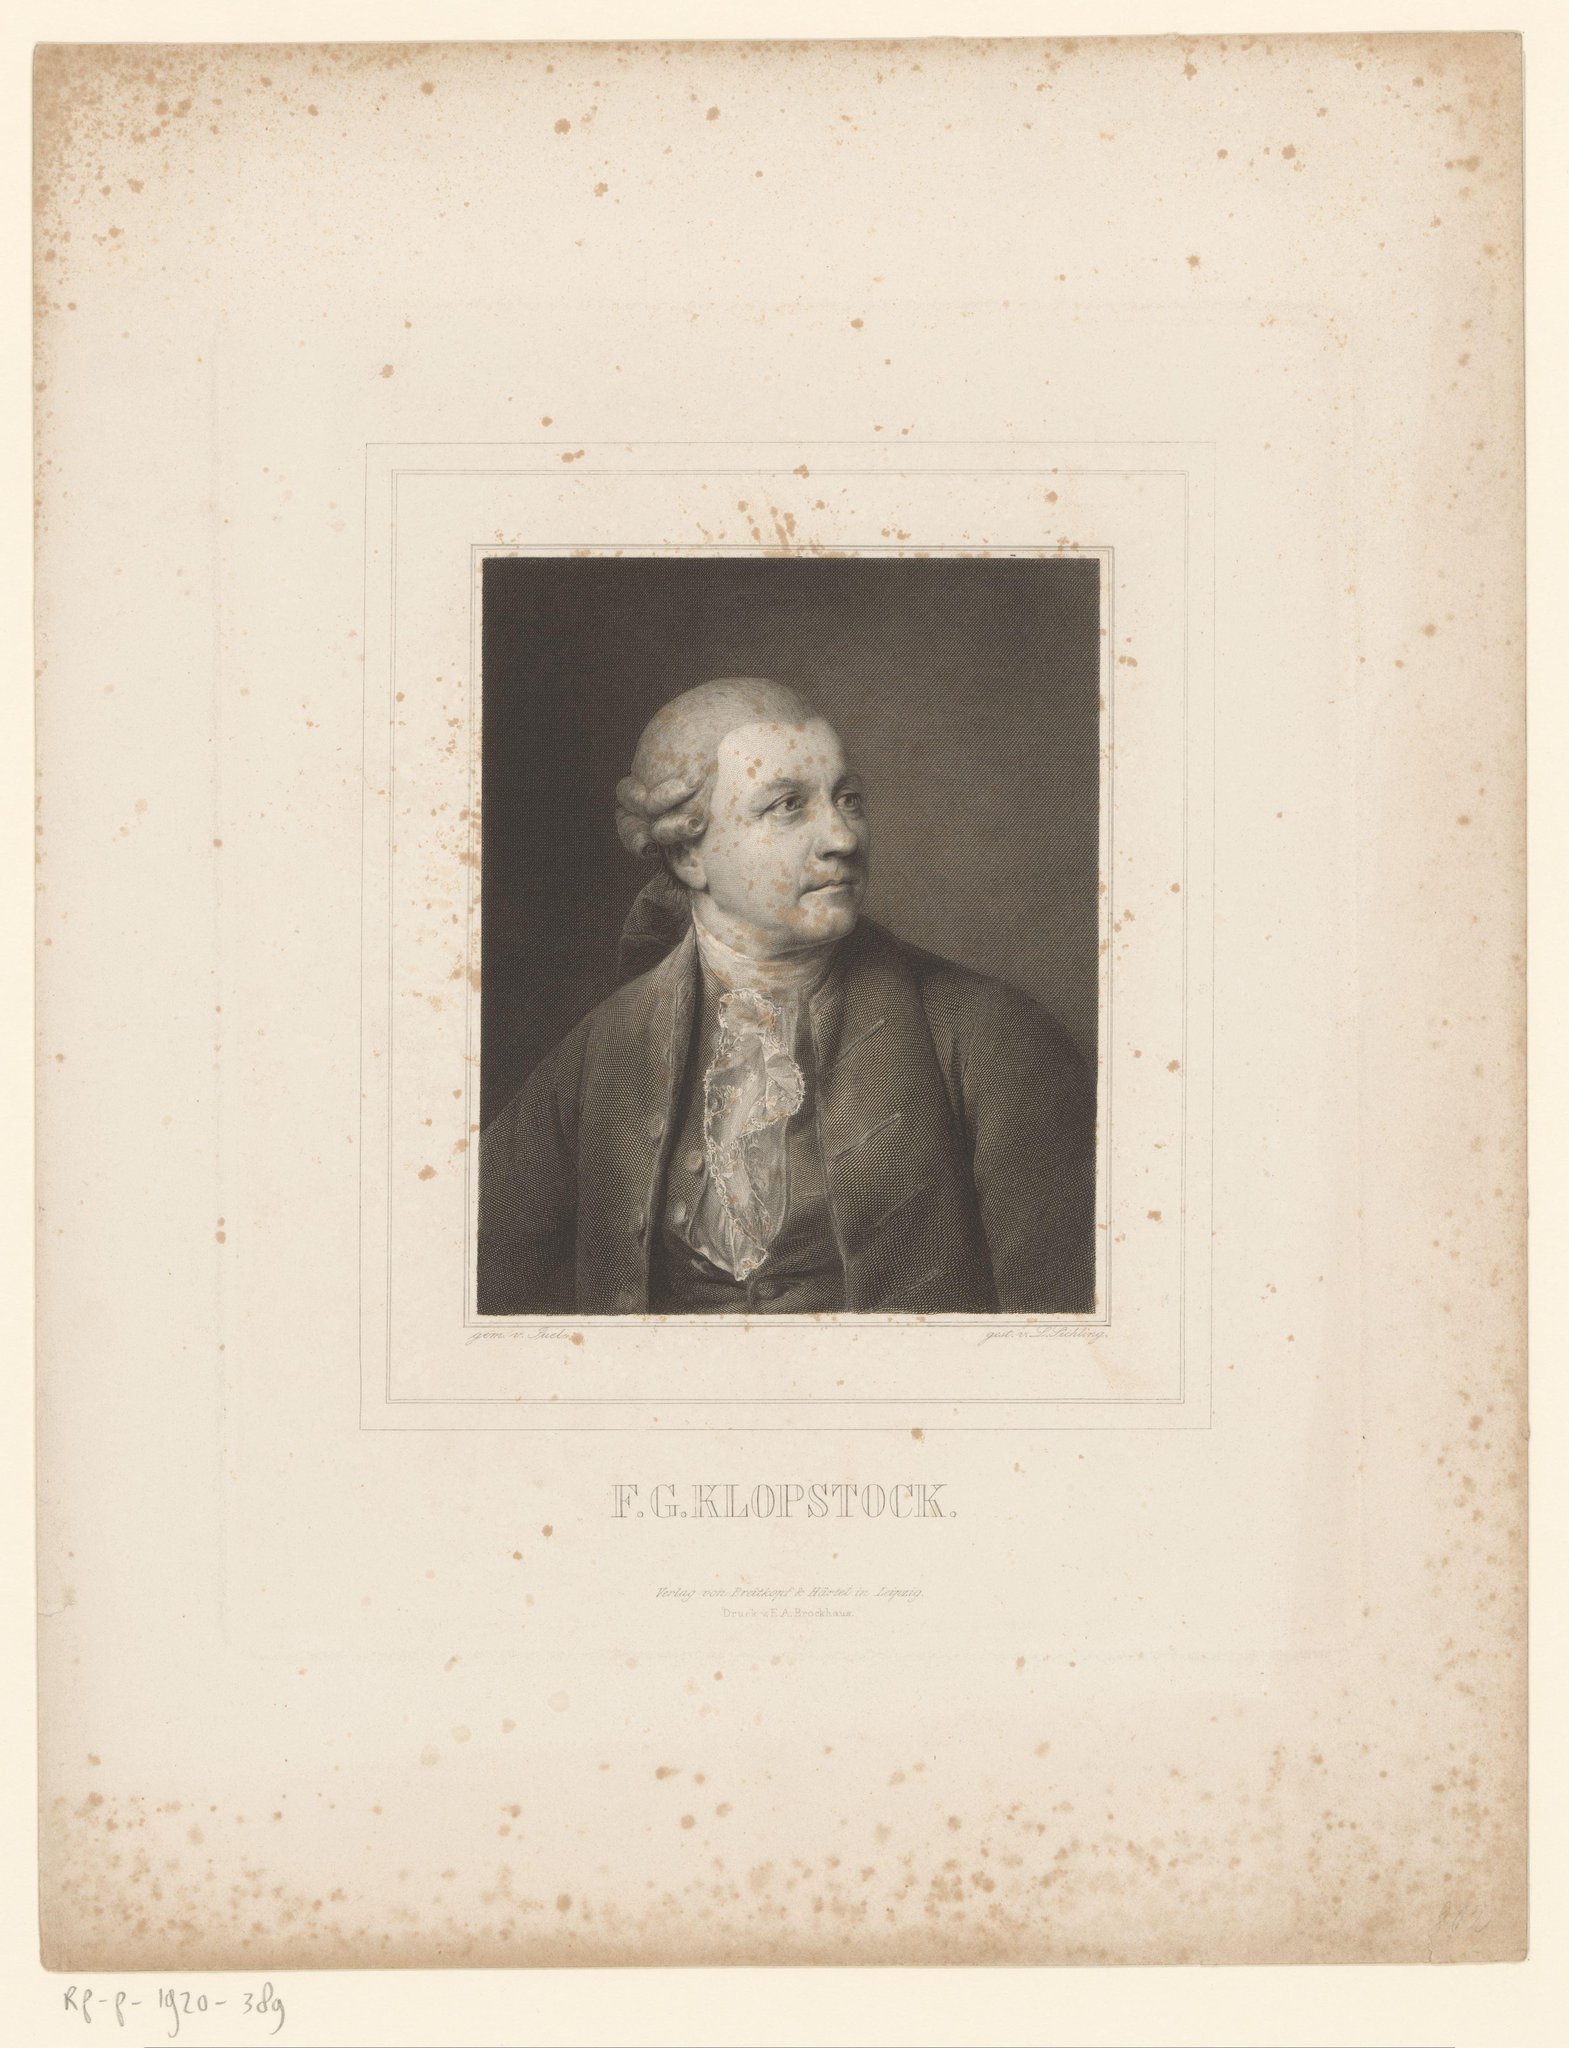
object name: print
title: Portret van Friedrich Gottlieb Klopstock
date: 1822-1863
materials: paper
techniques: engraving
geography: leipzig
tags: historical persons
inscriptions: collector's mark: Lugt 2228